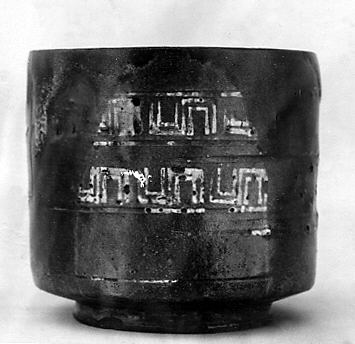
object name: teabowl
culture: japanese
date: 1701-1800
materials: clay, glaze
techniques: overglaze